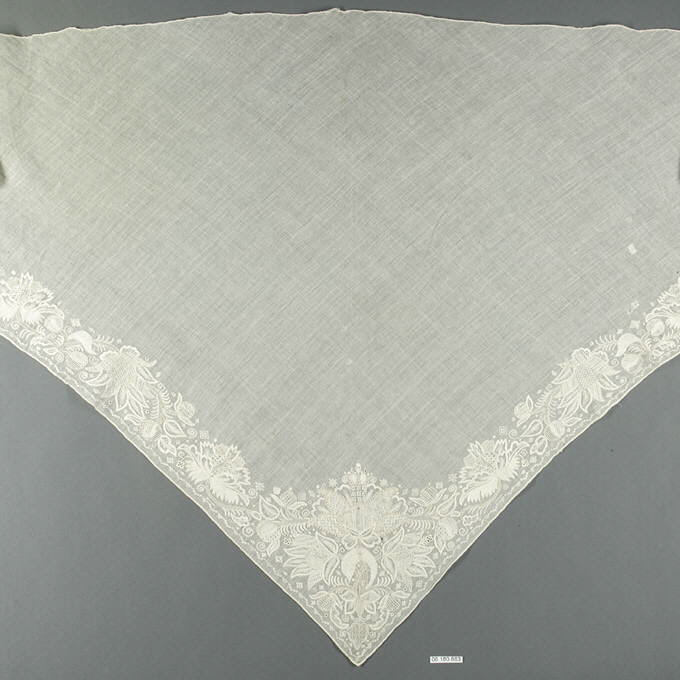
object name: kerchief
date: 1601-1700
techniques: embroidery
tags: flowers